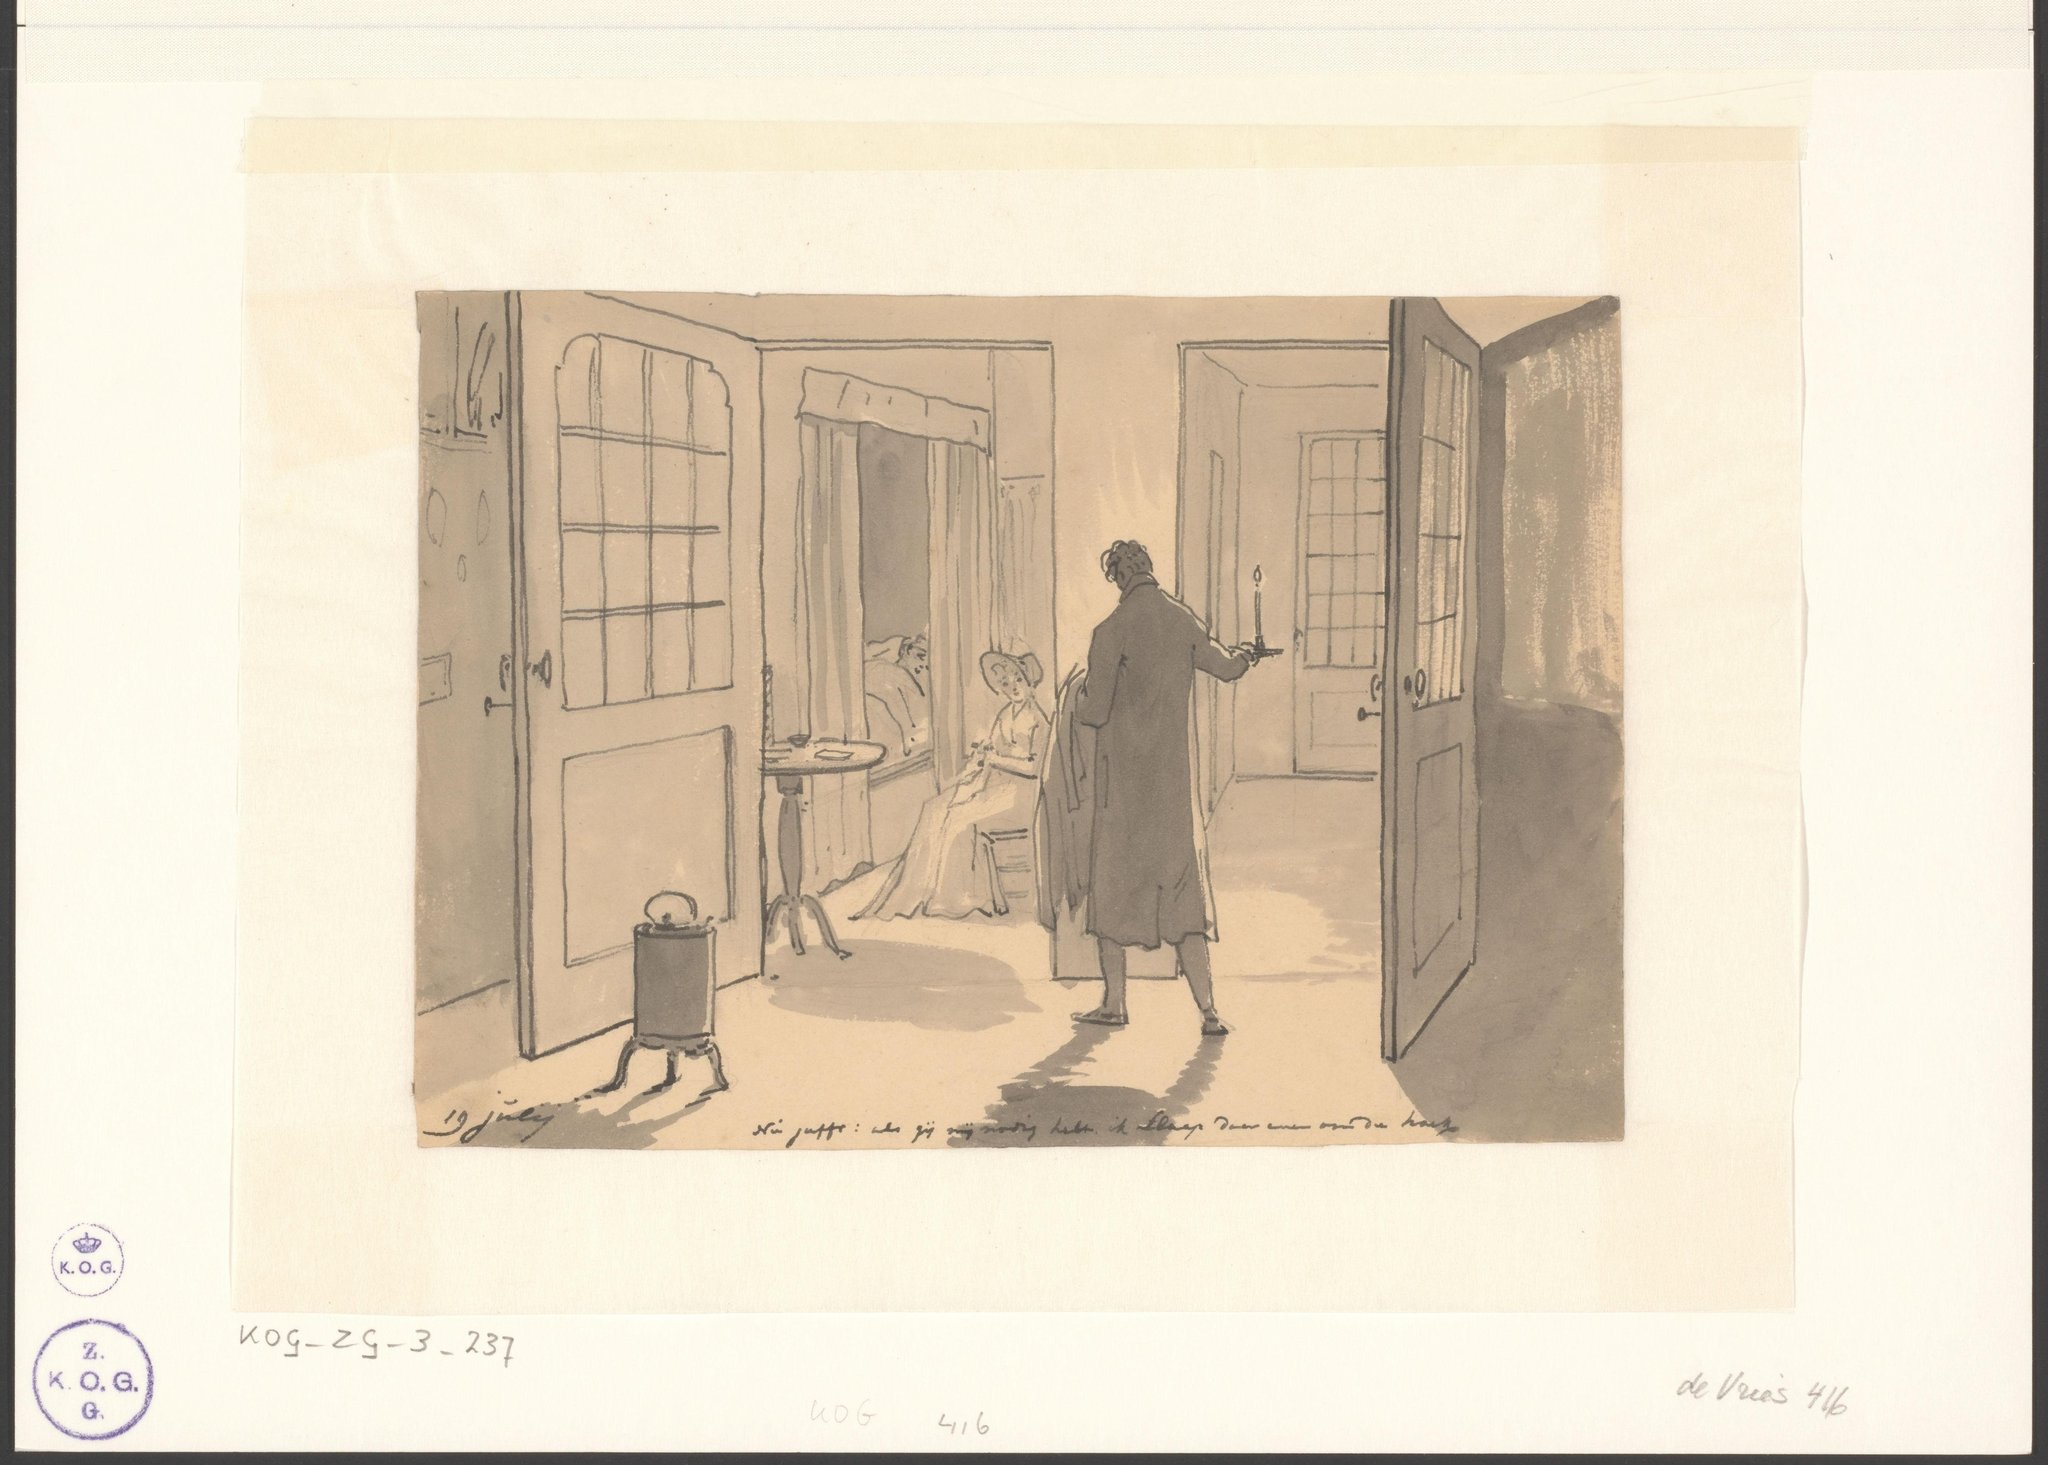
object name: drawing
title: Christiaan bezoekt de zieke Louis Zamore van Wicky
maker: christiaan andriessen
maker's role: draughtsman, print maker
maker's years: 1775-1846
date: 1805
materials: ink, paper, pencil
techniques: brush, pen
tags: print maker, draughtsman, christiaan andriessen, sick-bed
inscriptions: signature: ‘J Andriessen’, collector's mark: Lugt 1641, collector's mark: Lugt 1641a, inscription: ‘19 julij Nu juffr: als gij mij nodig hebt ik slaap daar even om de hoek’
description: Dagboekblad uit het getekende dagboek dat Christiaan Andriessen bijhield van 1805 tot en met 1808.